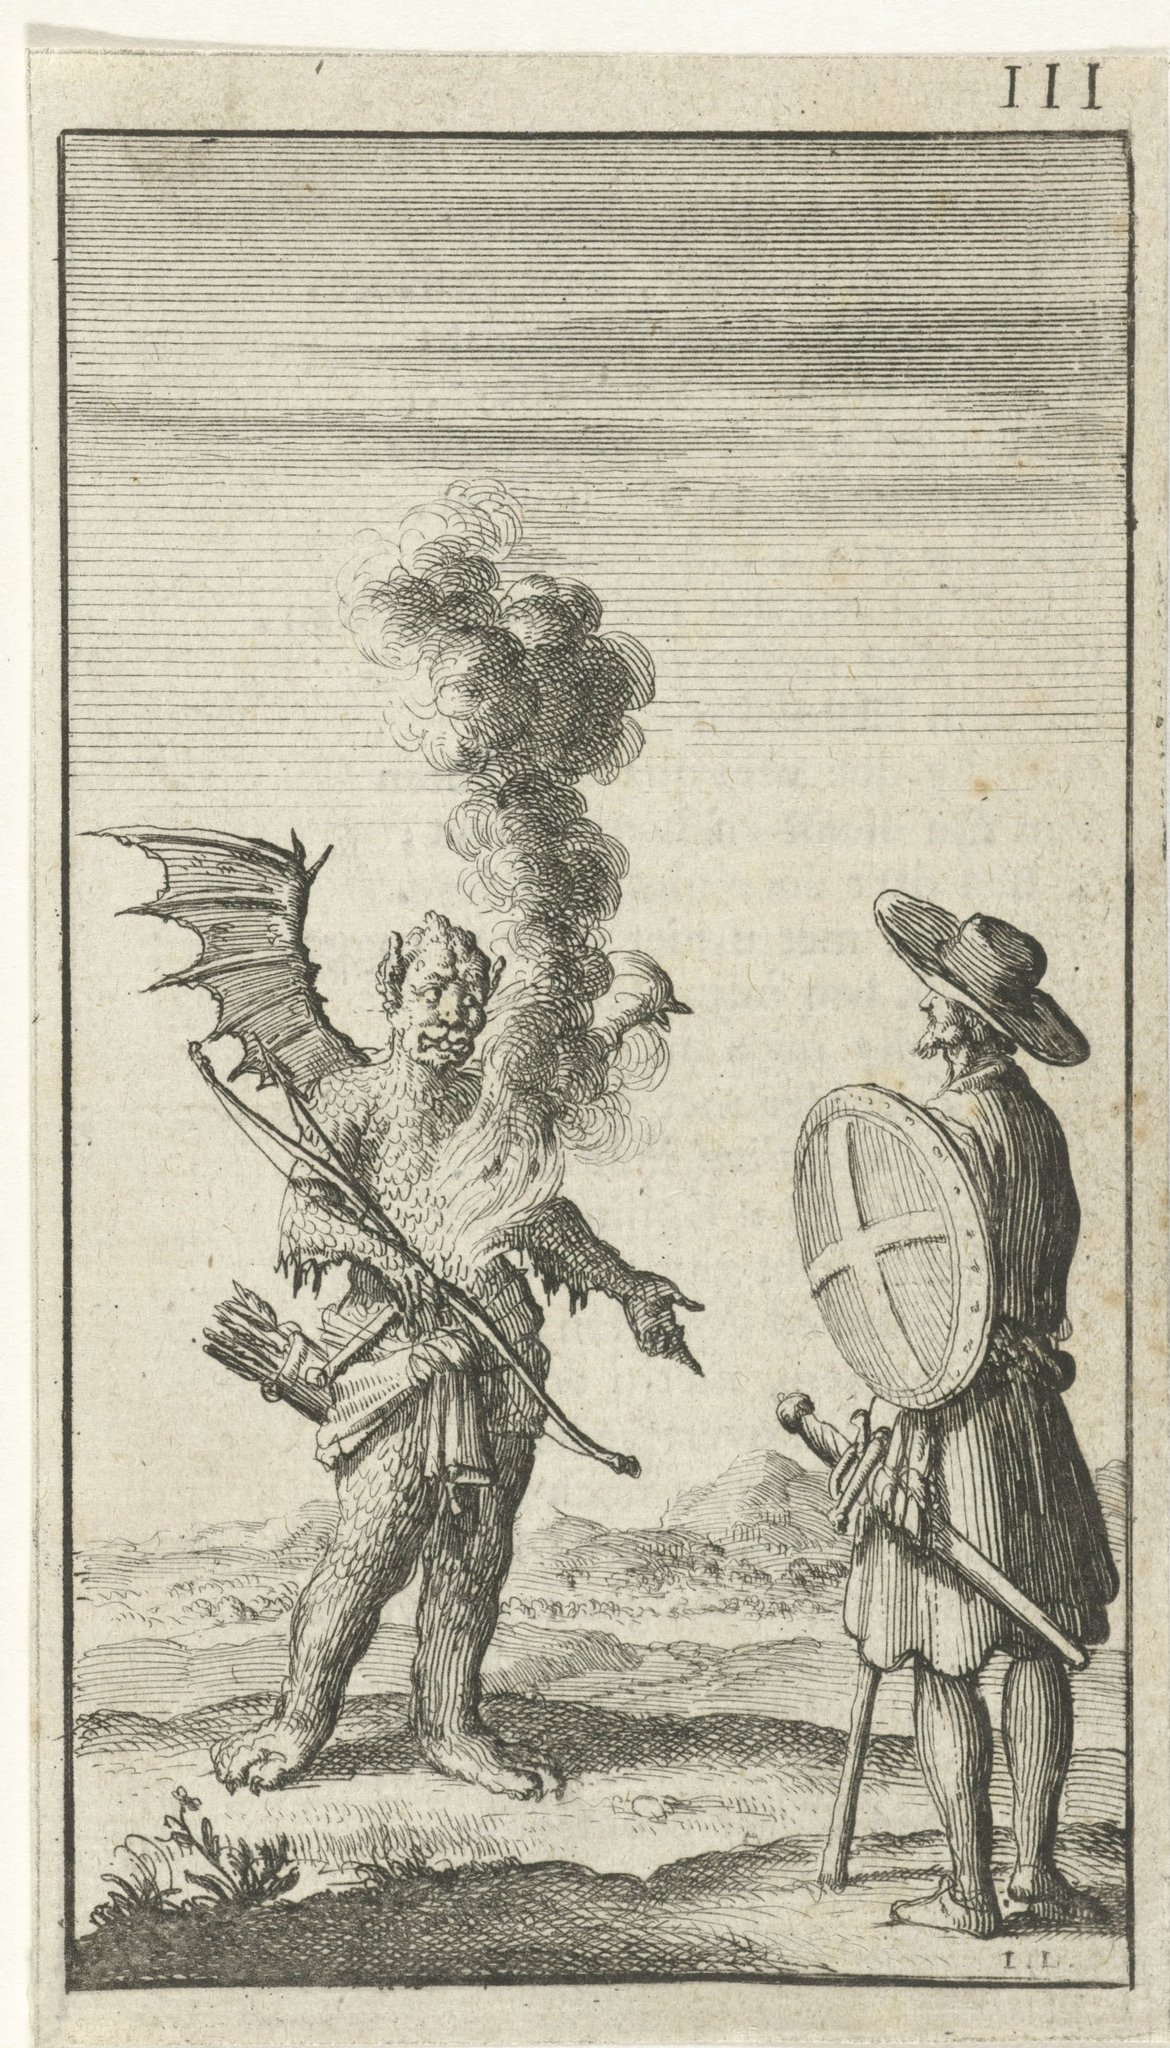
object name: print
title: Christen ontmoet Apollyon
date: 1684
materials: paper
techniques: etching, letterpress printing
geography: amsterdam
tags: devil(s) and demons (with name)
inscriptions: collector's mark: Lugt 2228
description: Illustratie uit: Bunyan, John. Eens christens reyse na de eeuwigheyt. Amsterdam: Johannes Boekholt, 1684.